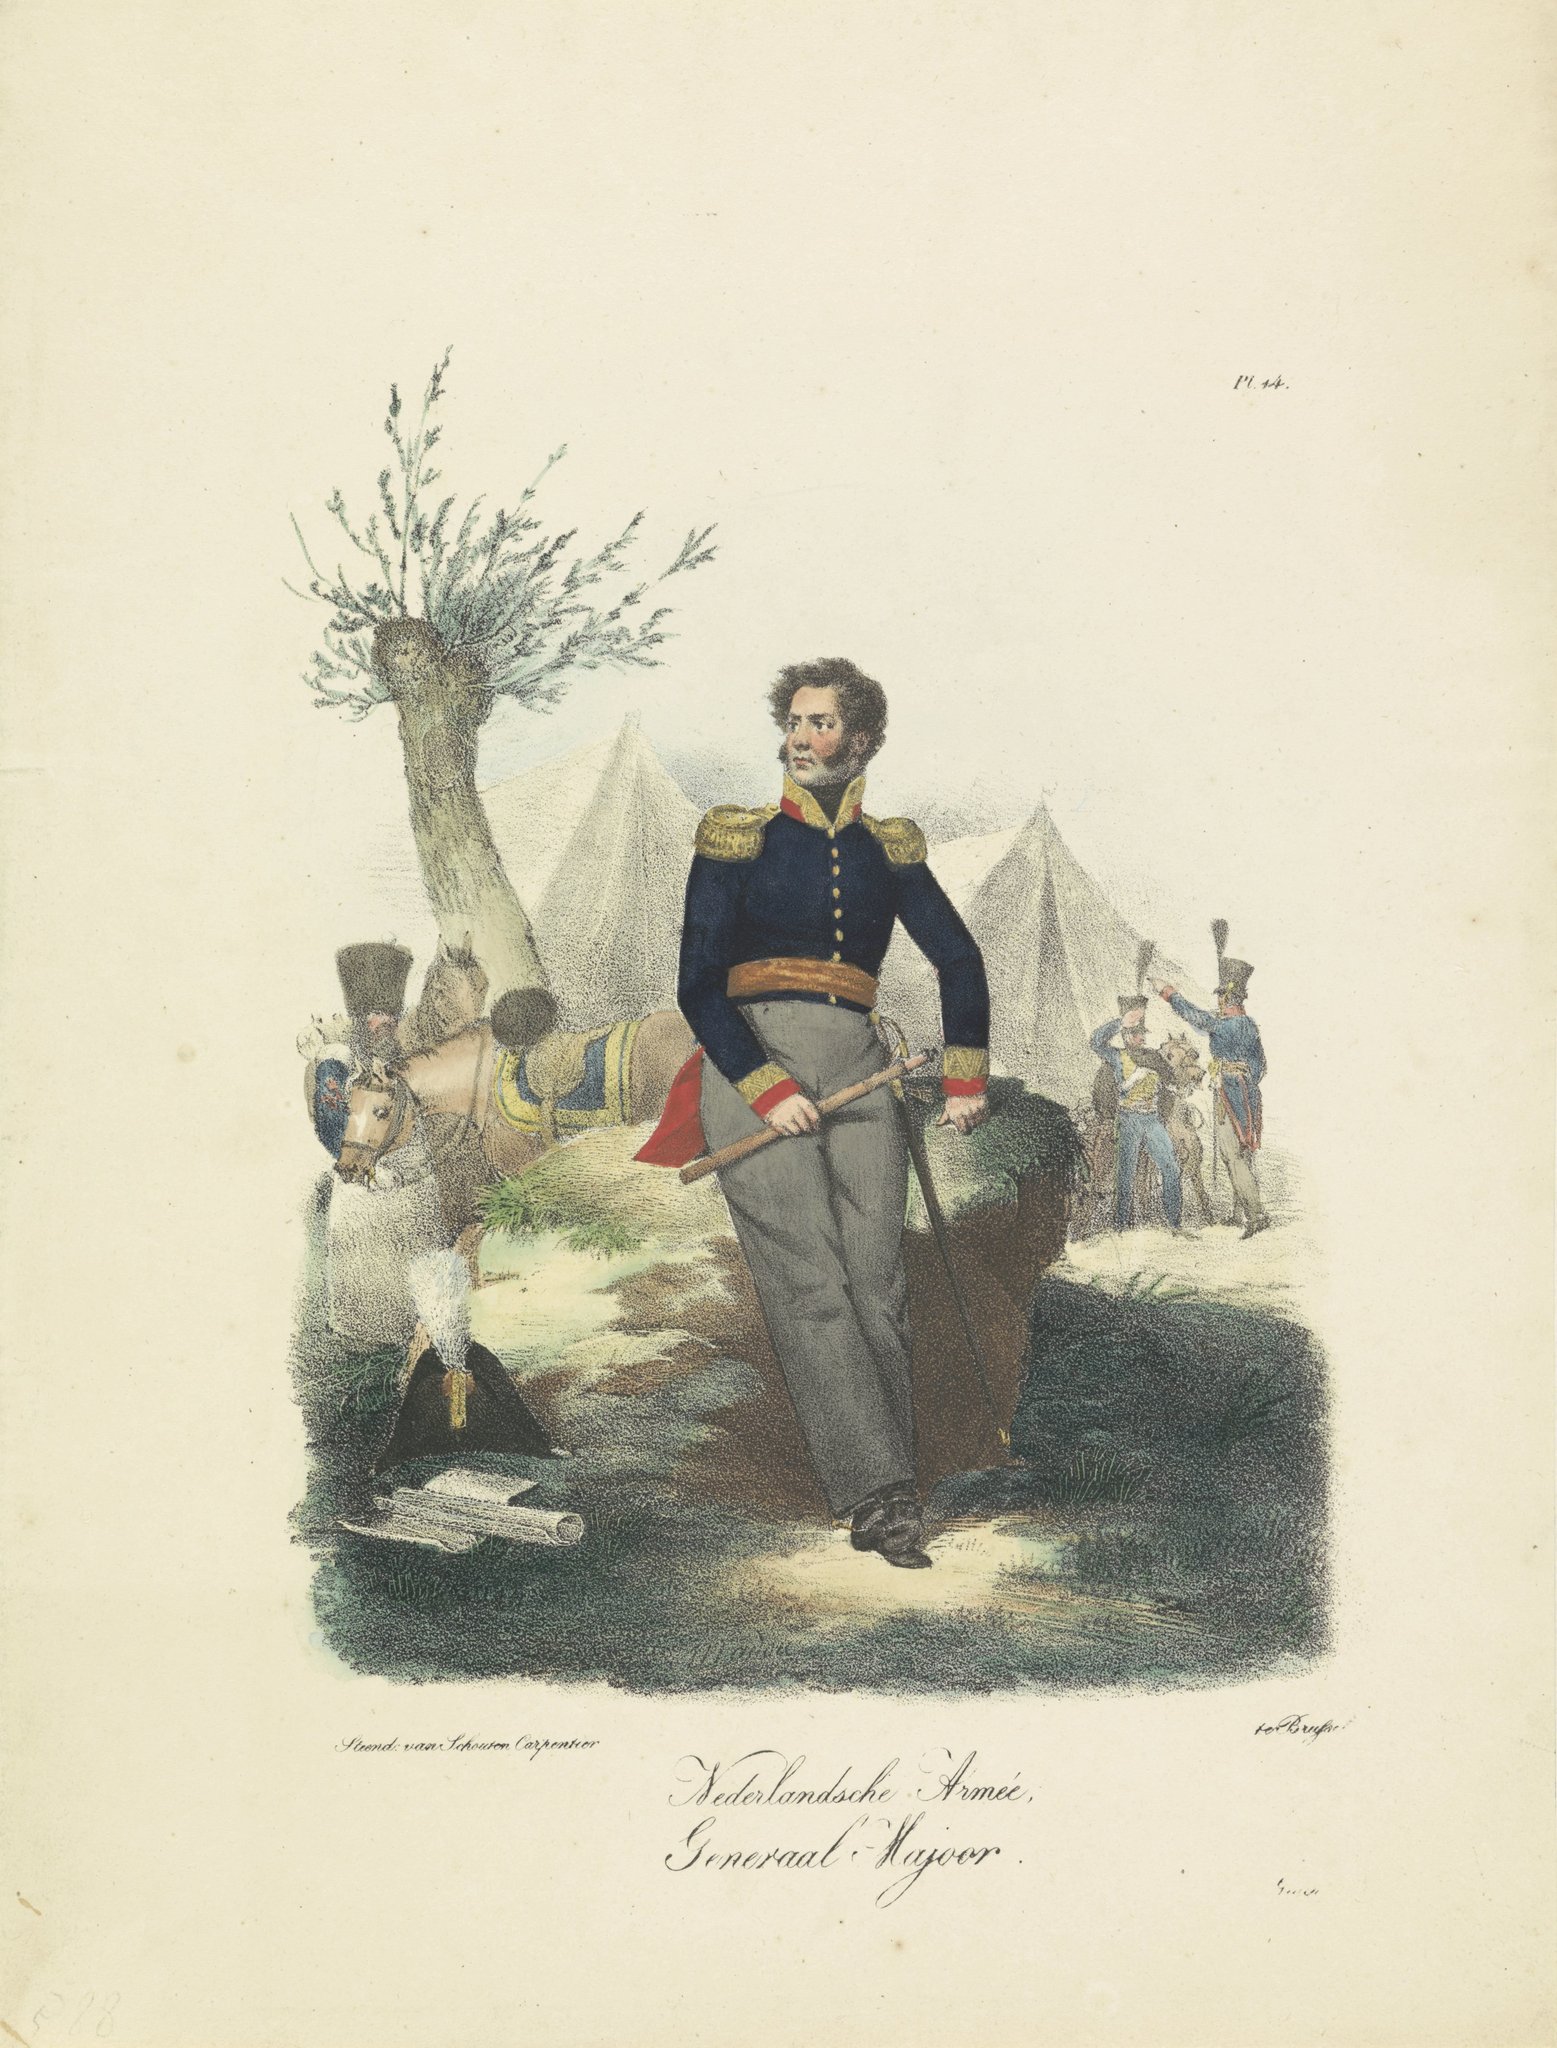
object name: costume print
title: Militaire costumen van het Koninkryk der Nederlanden. Opgedragen aan zyne excellentie Willem van Bylandt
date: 1825-1827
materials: paper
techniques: hand coloring, lithograph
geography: brussels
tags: (military) uniforms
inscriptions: collector's mark: Lugt 2228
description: Uniformvoorstelling van een generaal-majoor, geleund tegen een rotsblok. Genummerd rechtsboven: Pl. 14. Onderdeel van de reeks van 53 platen van uniformen van de militairen van het Koninkrijk der Nederlanden in de periode 1820-1825.